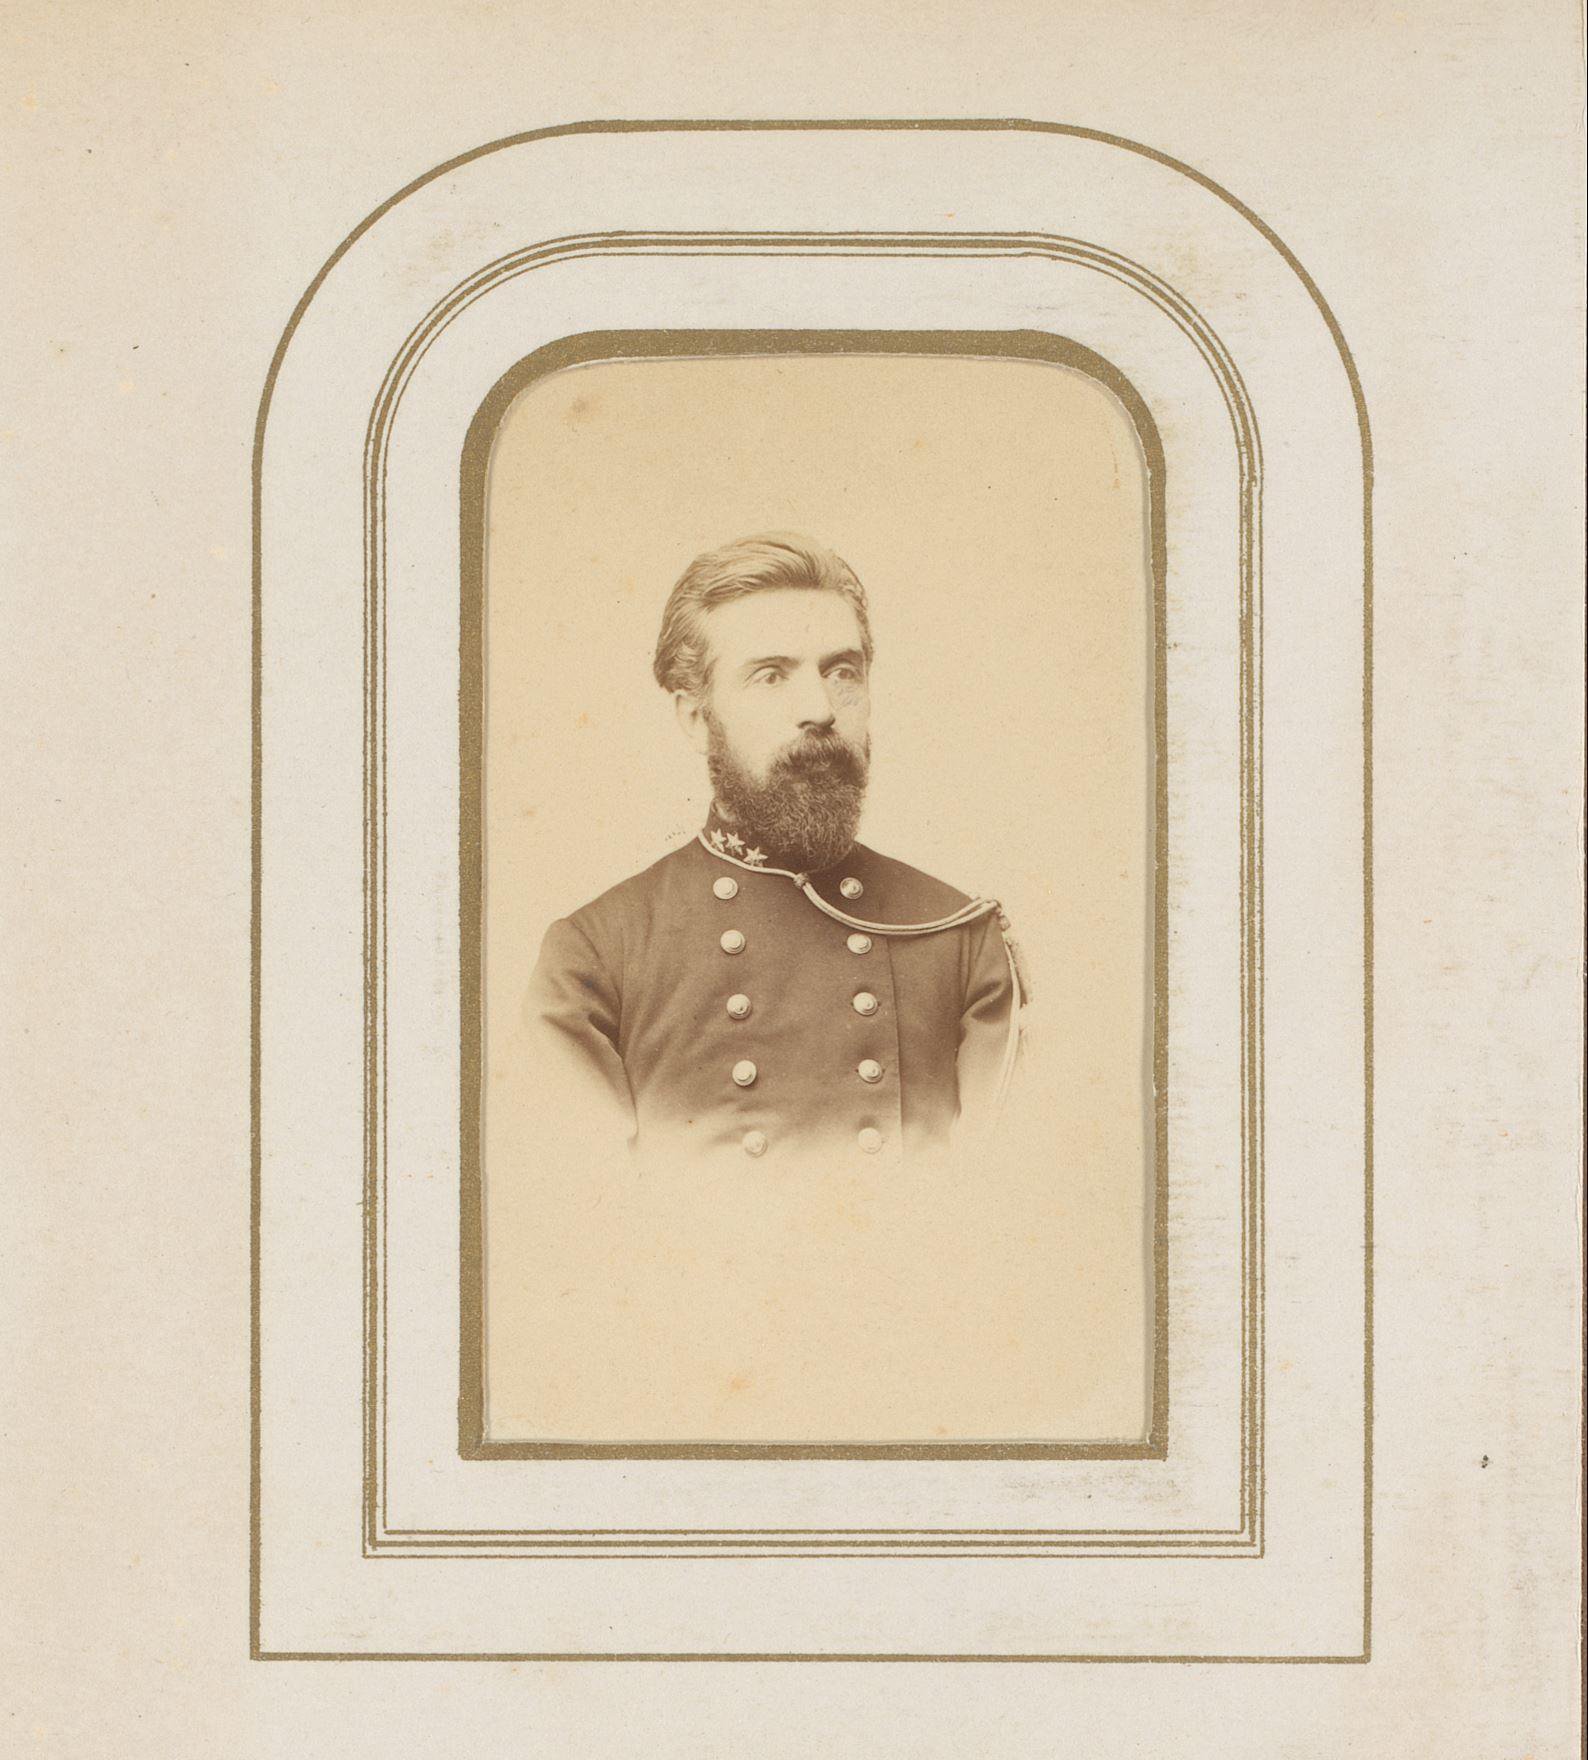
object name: album leaf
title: Portret van een man met baard in uniform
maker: albert delabarre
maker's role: musician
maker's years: 1809-1885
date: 1866-1884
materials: cardboard, photographic support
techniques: albumen print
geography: brussels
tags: historical persons, (military) uniforms, beard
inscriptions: number: ‘11’, inscription: ‘Photographie Parisienne/ 36, Rue Fossé aux Loups, 36/ (Place de la Monnaie)/ Bruxelles’